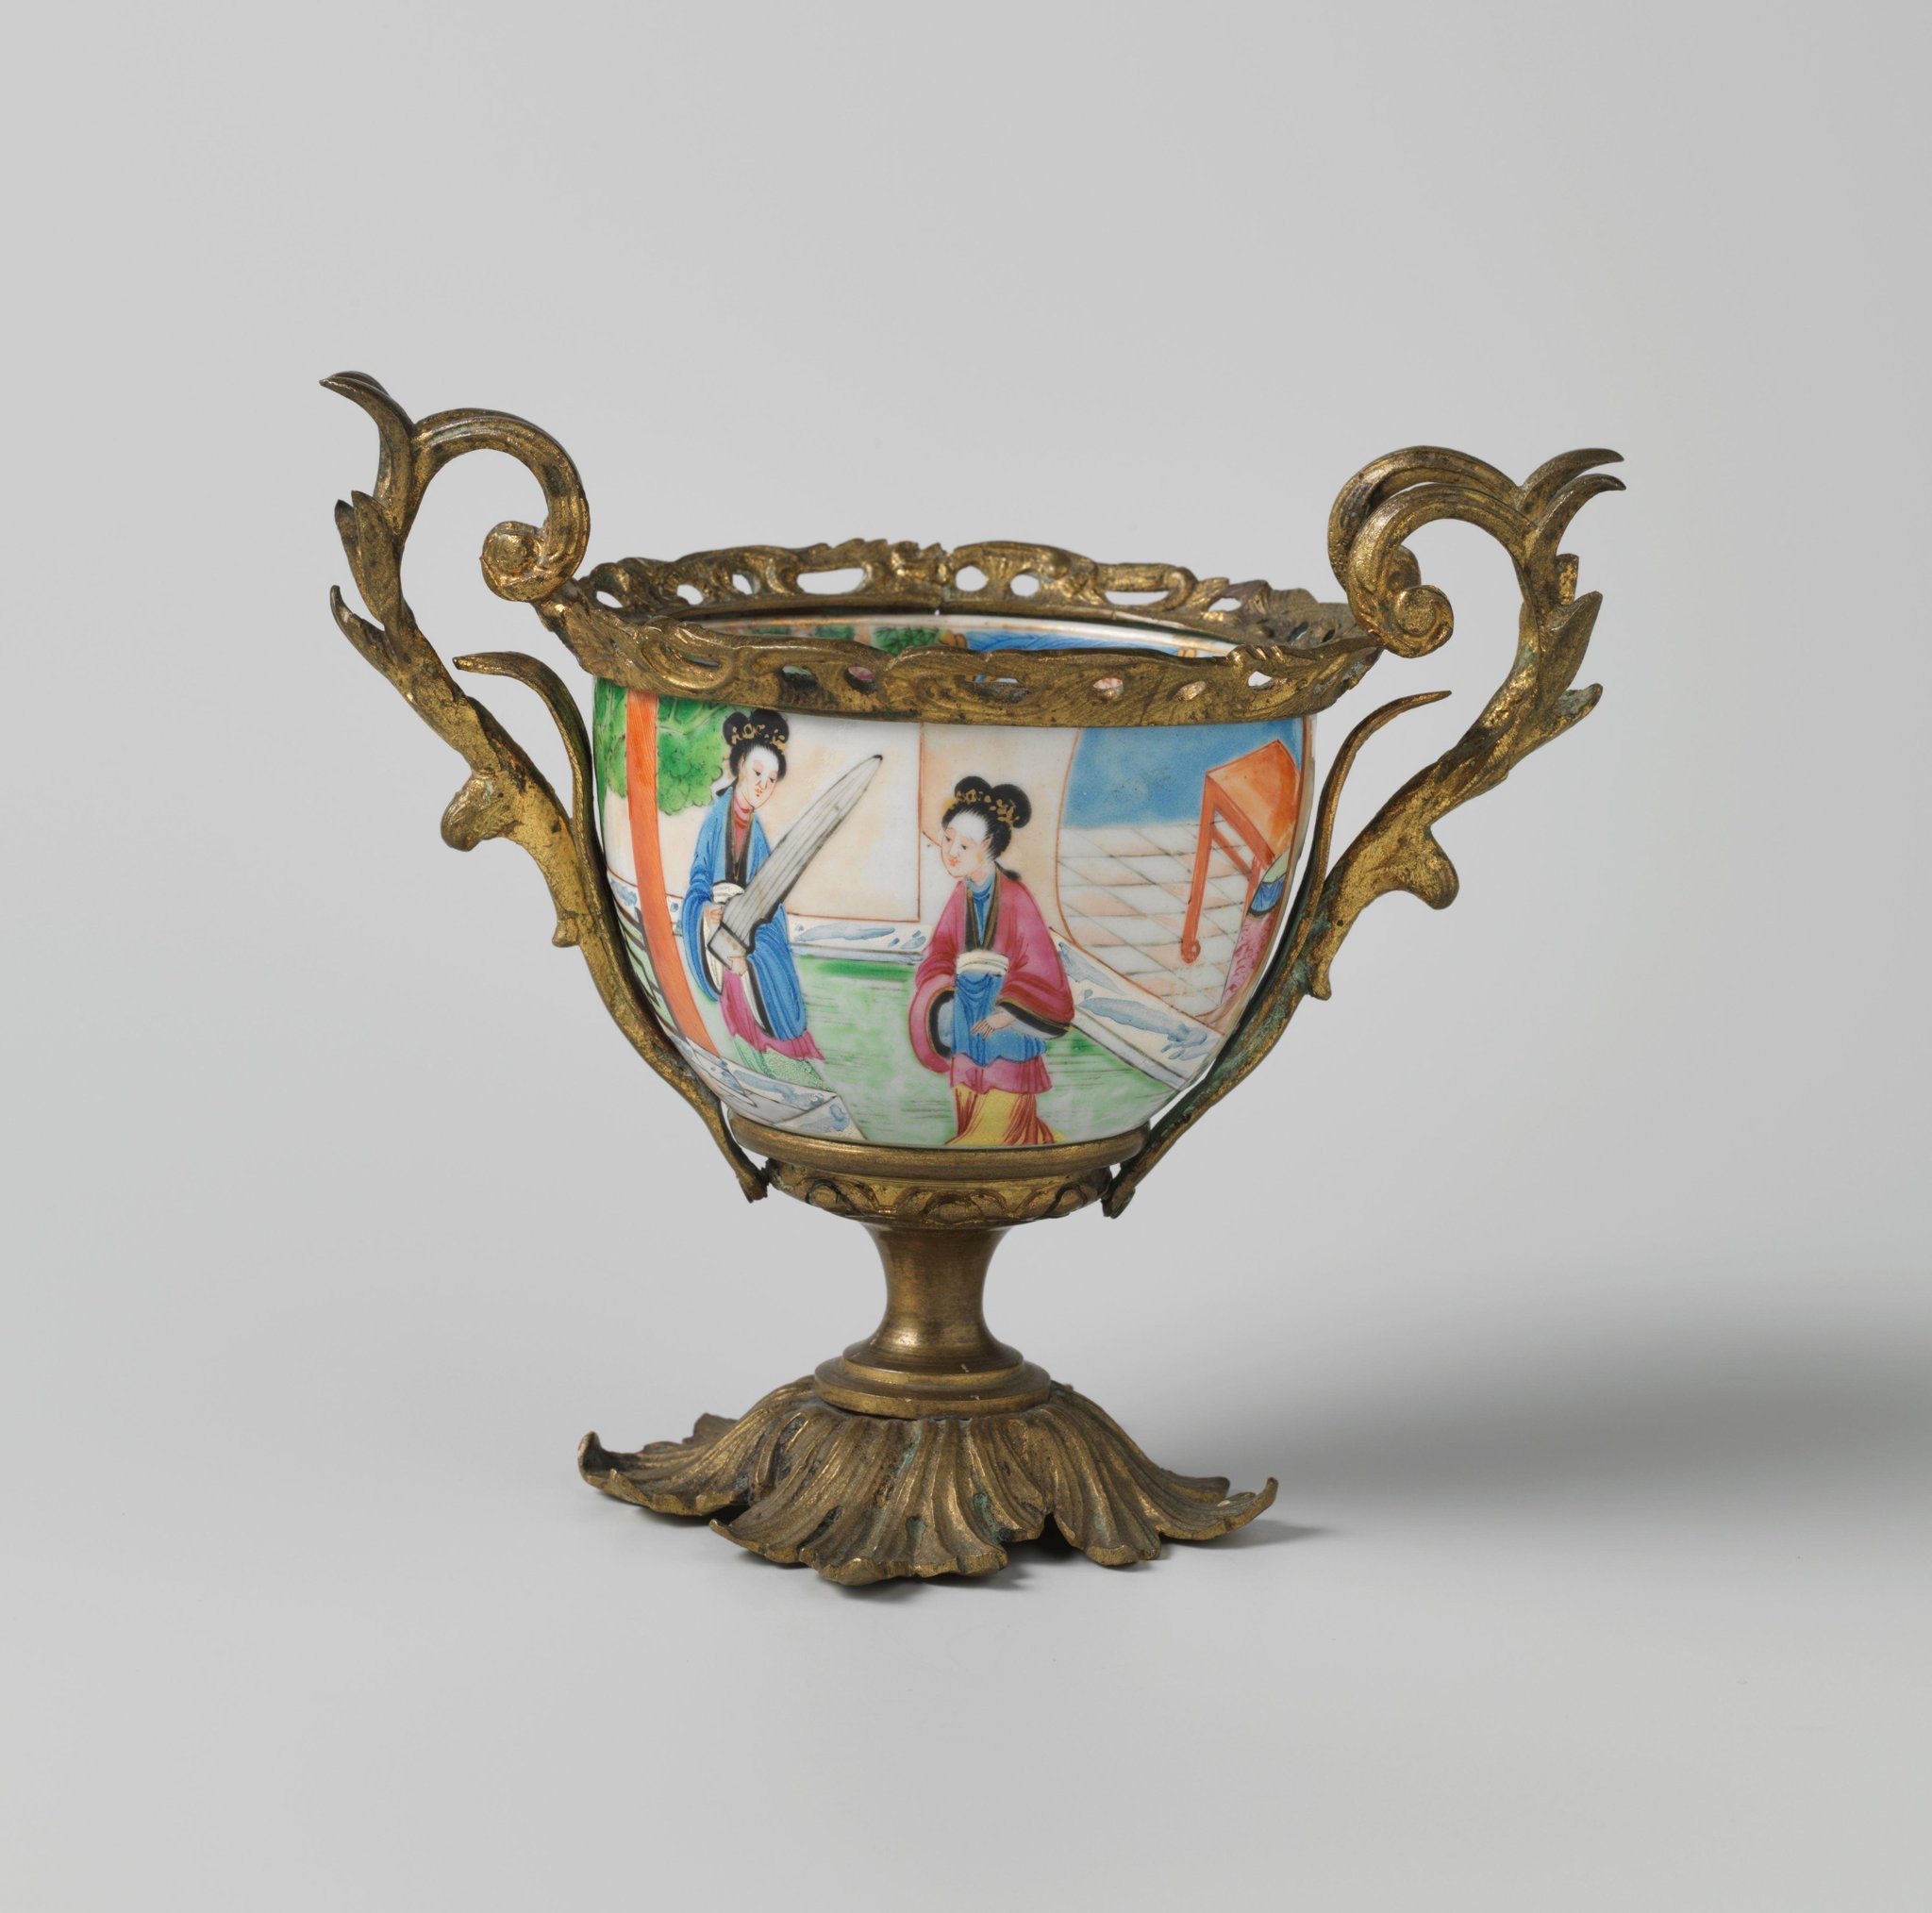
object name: coupe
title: Coupe Van Speyk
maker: Anonymous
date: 1831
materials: copper, porcelain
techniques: casting, firing, planed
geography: netherlands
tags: amsterdam, antwerp, jan van speyk